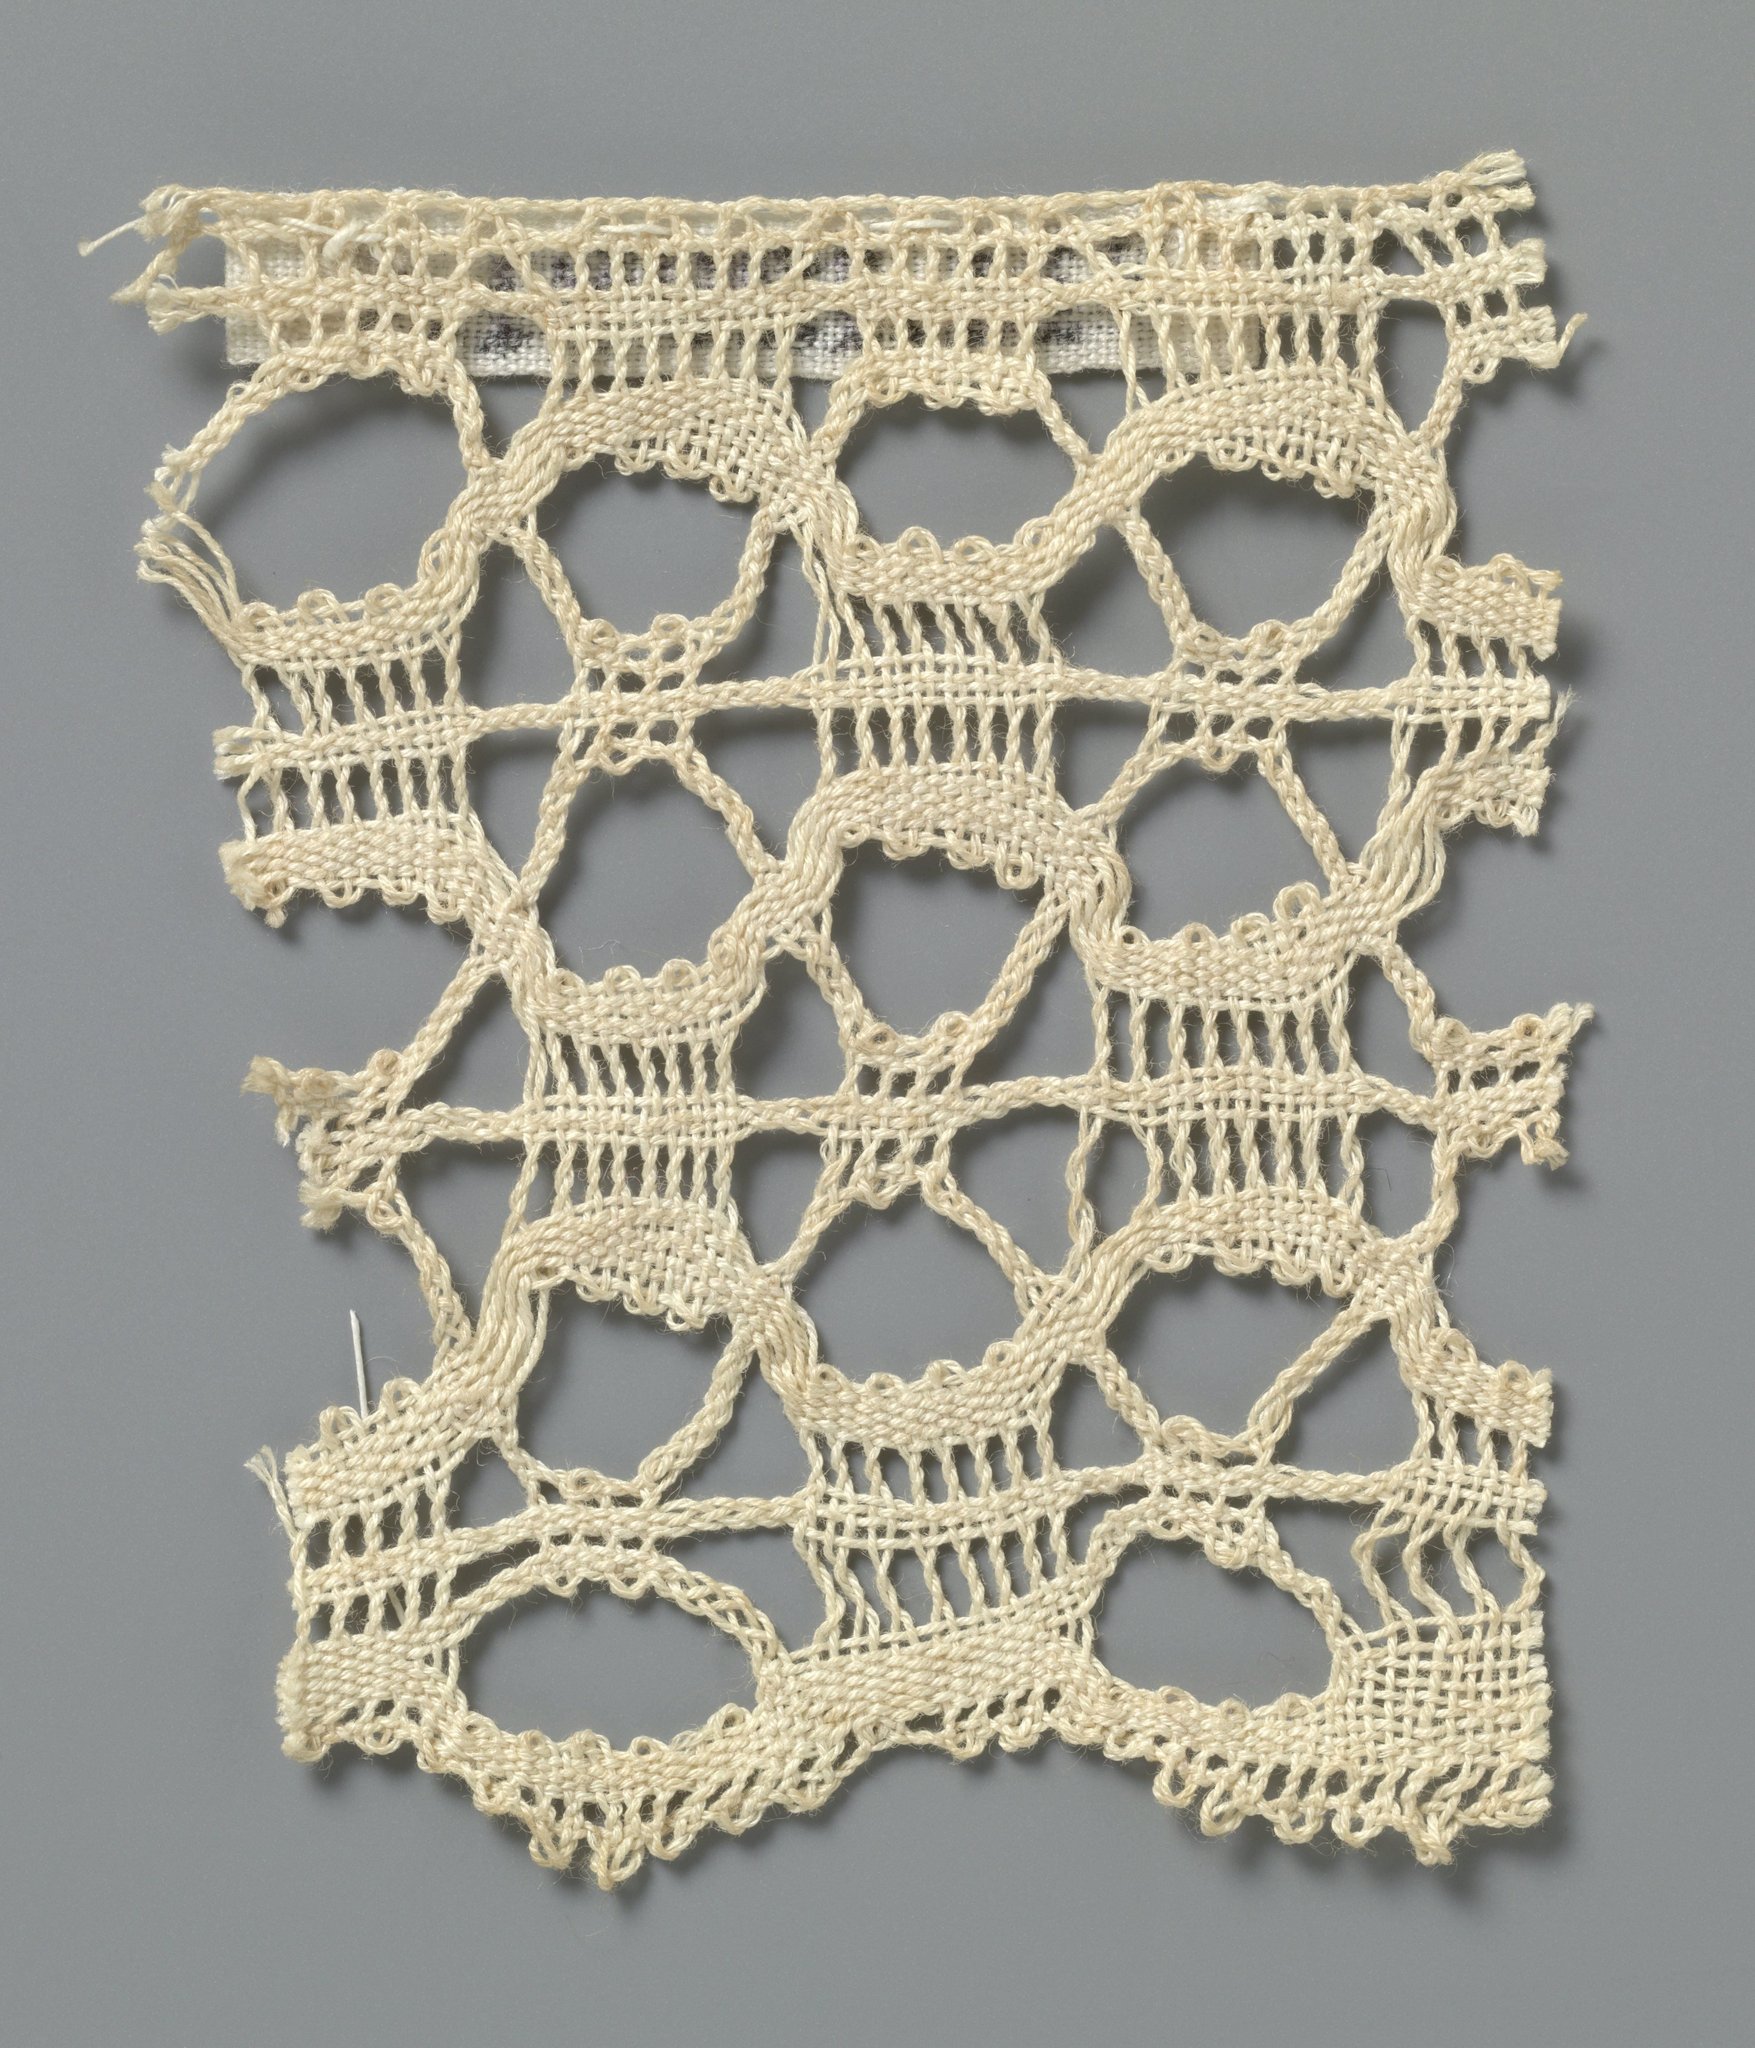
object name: strip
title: Strook kloskant met rijen staande ovalen met een kruis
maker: Anonymous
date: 1800-1899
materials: linen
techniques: lace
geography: brazil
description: Strook naturelkleurige kloskant. Het patroon bestaat uit drie rijen ovalen met een kruis erin, afgewisseld door gestreepte blokjes. De ovalen worden gevormd door golvende linten tussen horizontale lijnen. De bovenzijde van de strook is recht afgewerkt. De schulpen langs de onderzijde worden gevormd door het onderste golvende lint, dat onderaan is voorzien van picots.